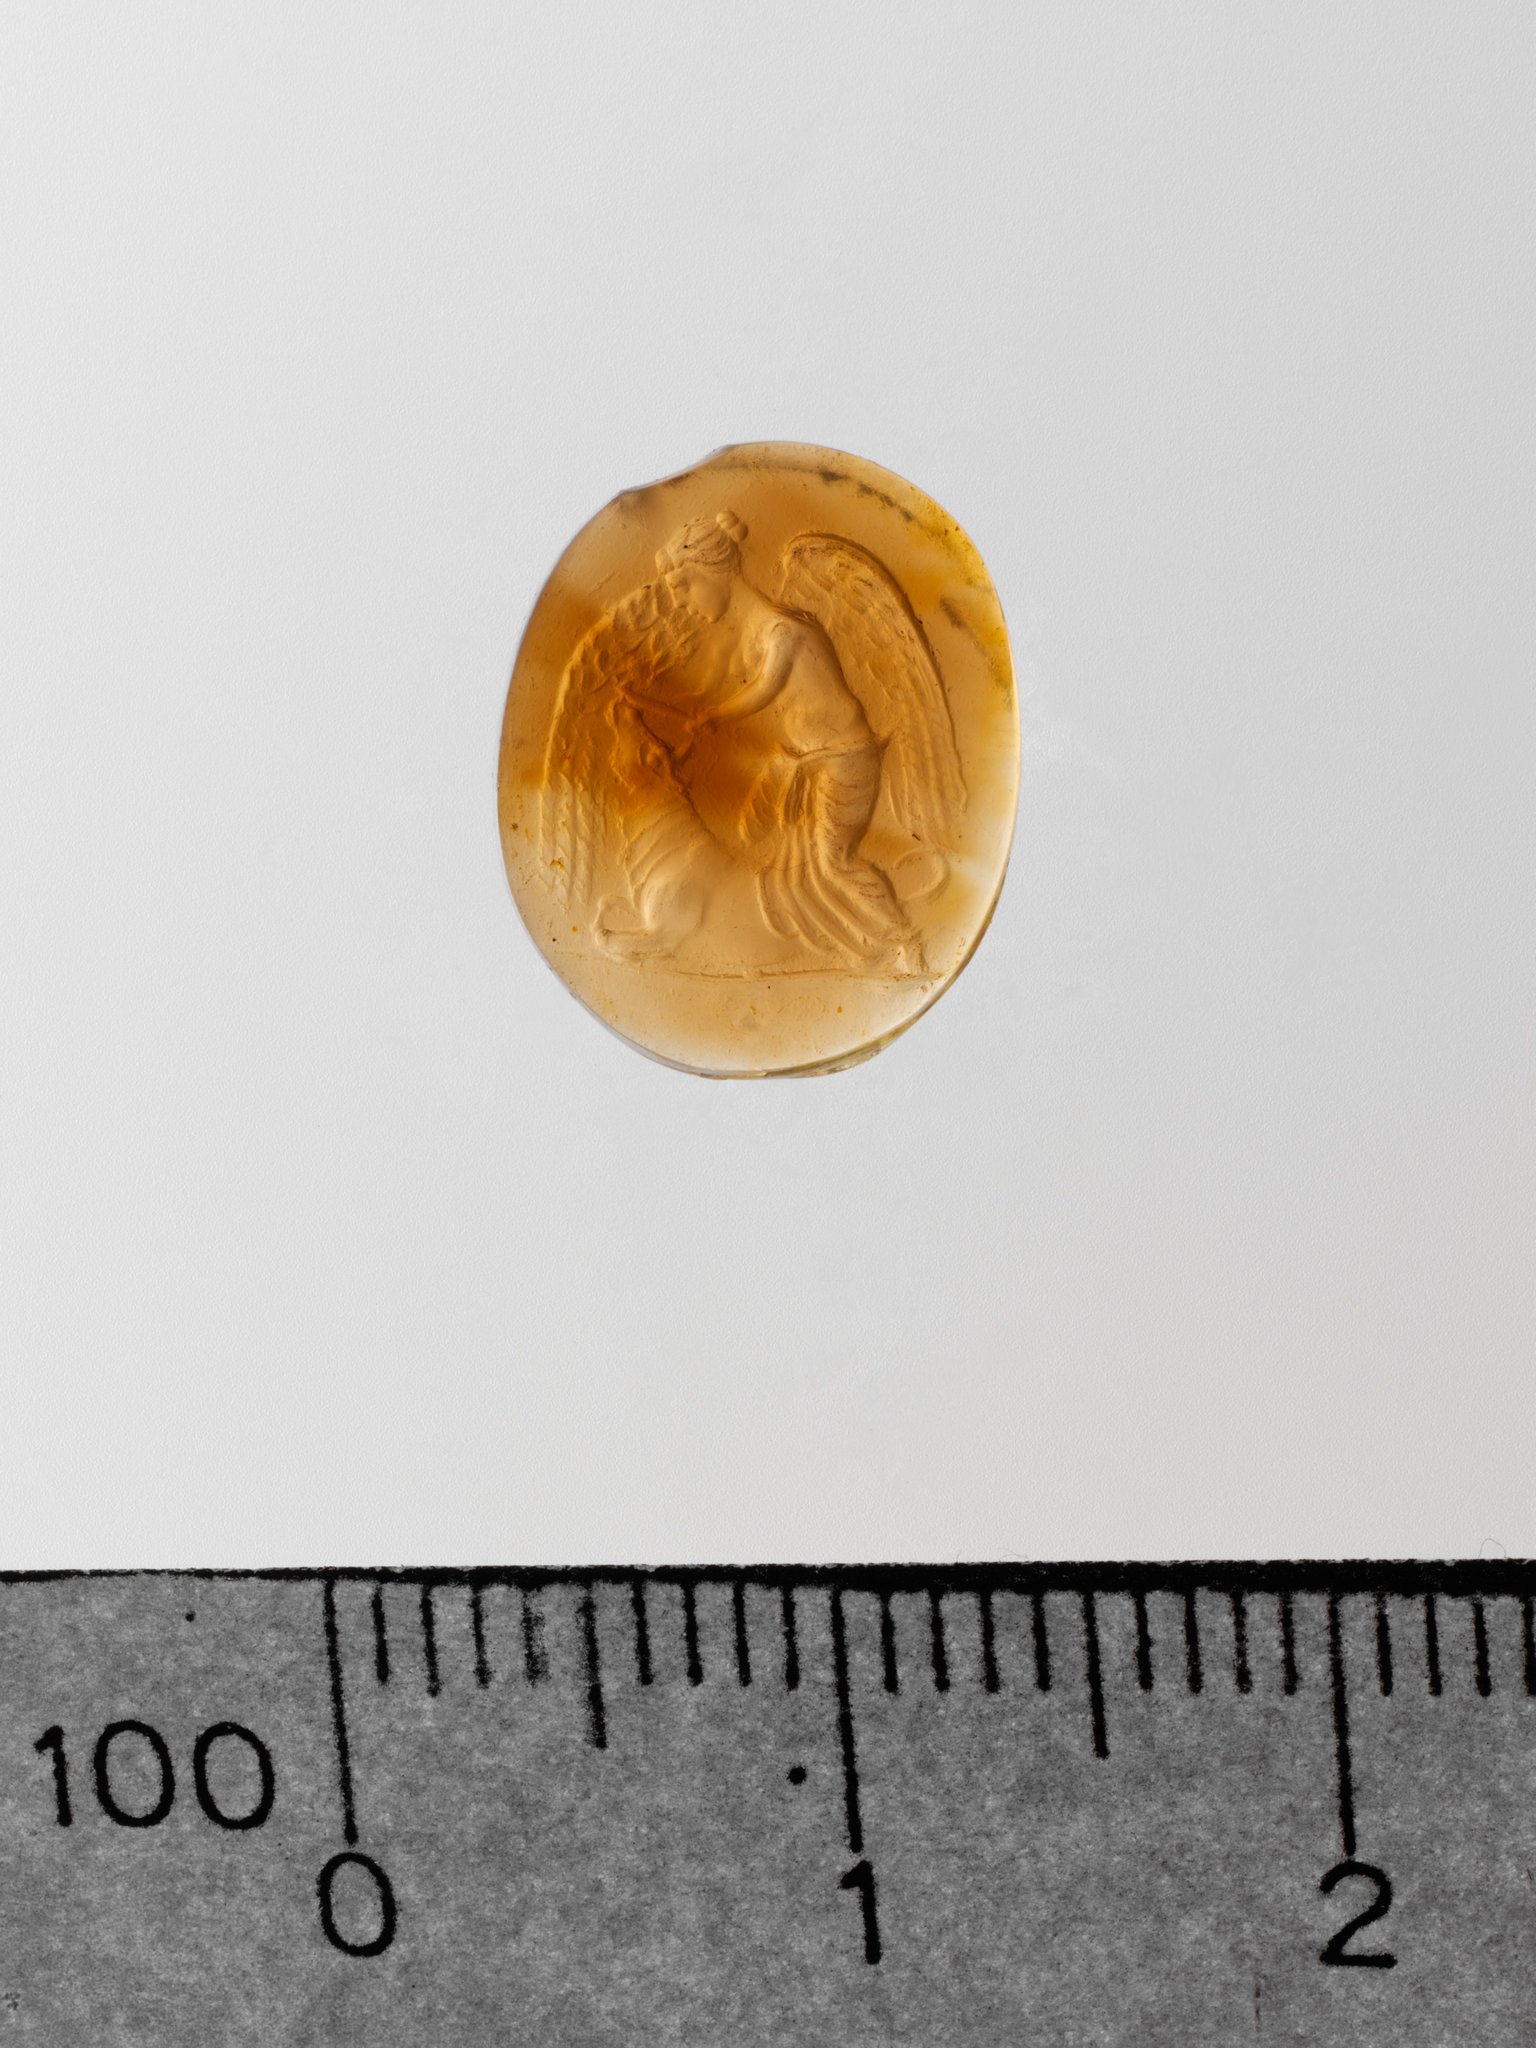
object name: intaglio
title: Chalcedony ring stone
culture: roman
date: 1-100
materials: stone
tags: nike,bulls